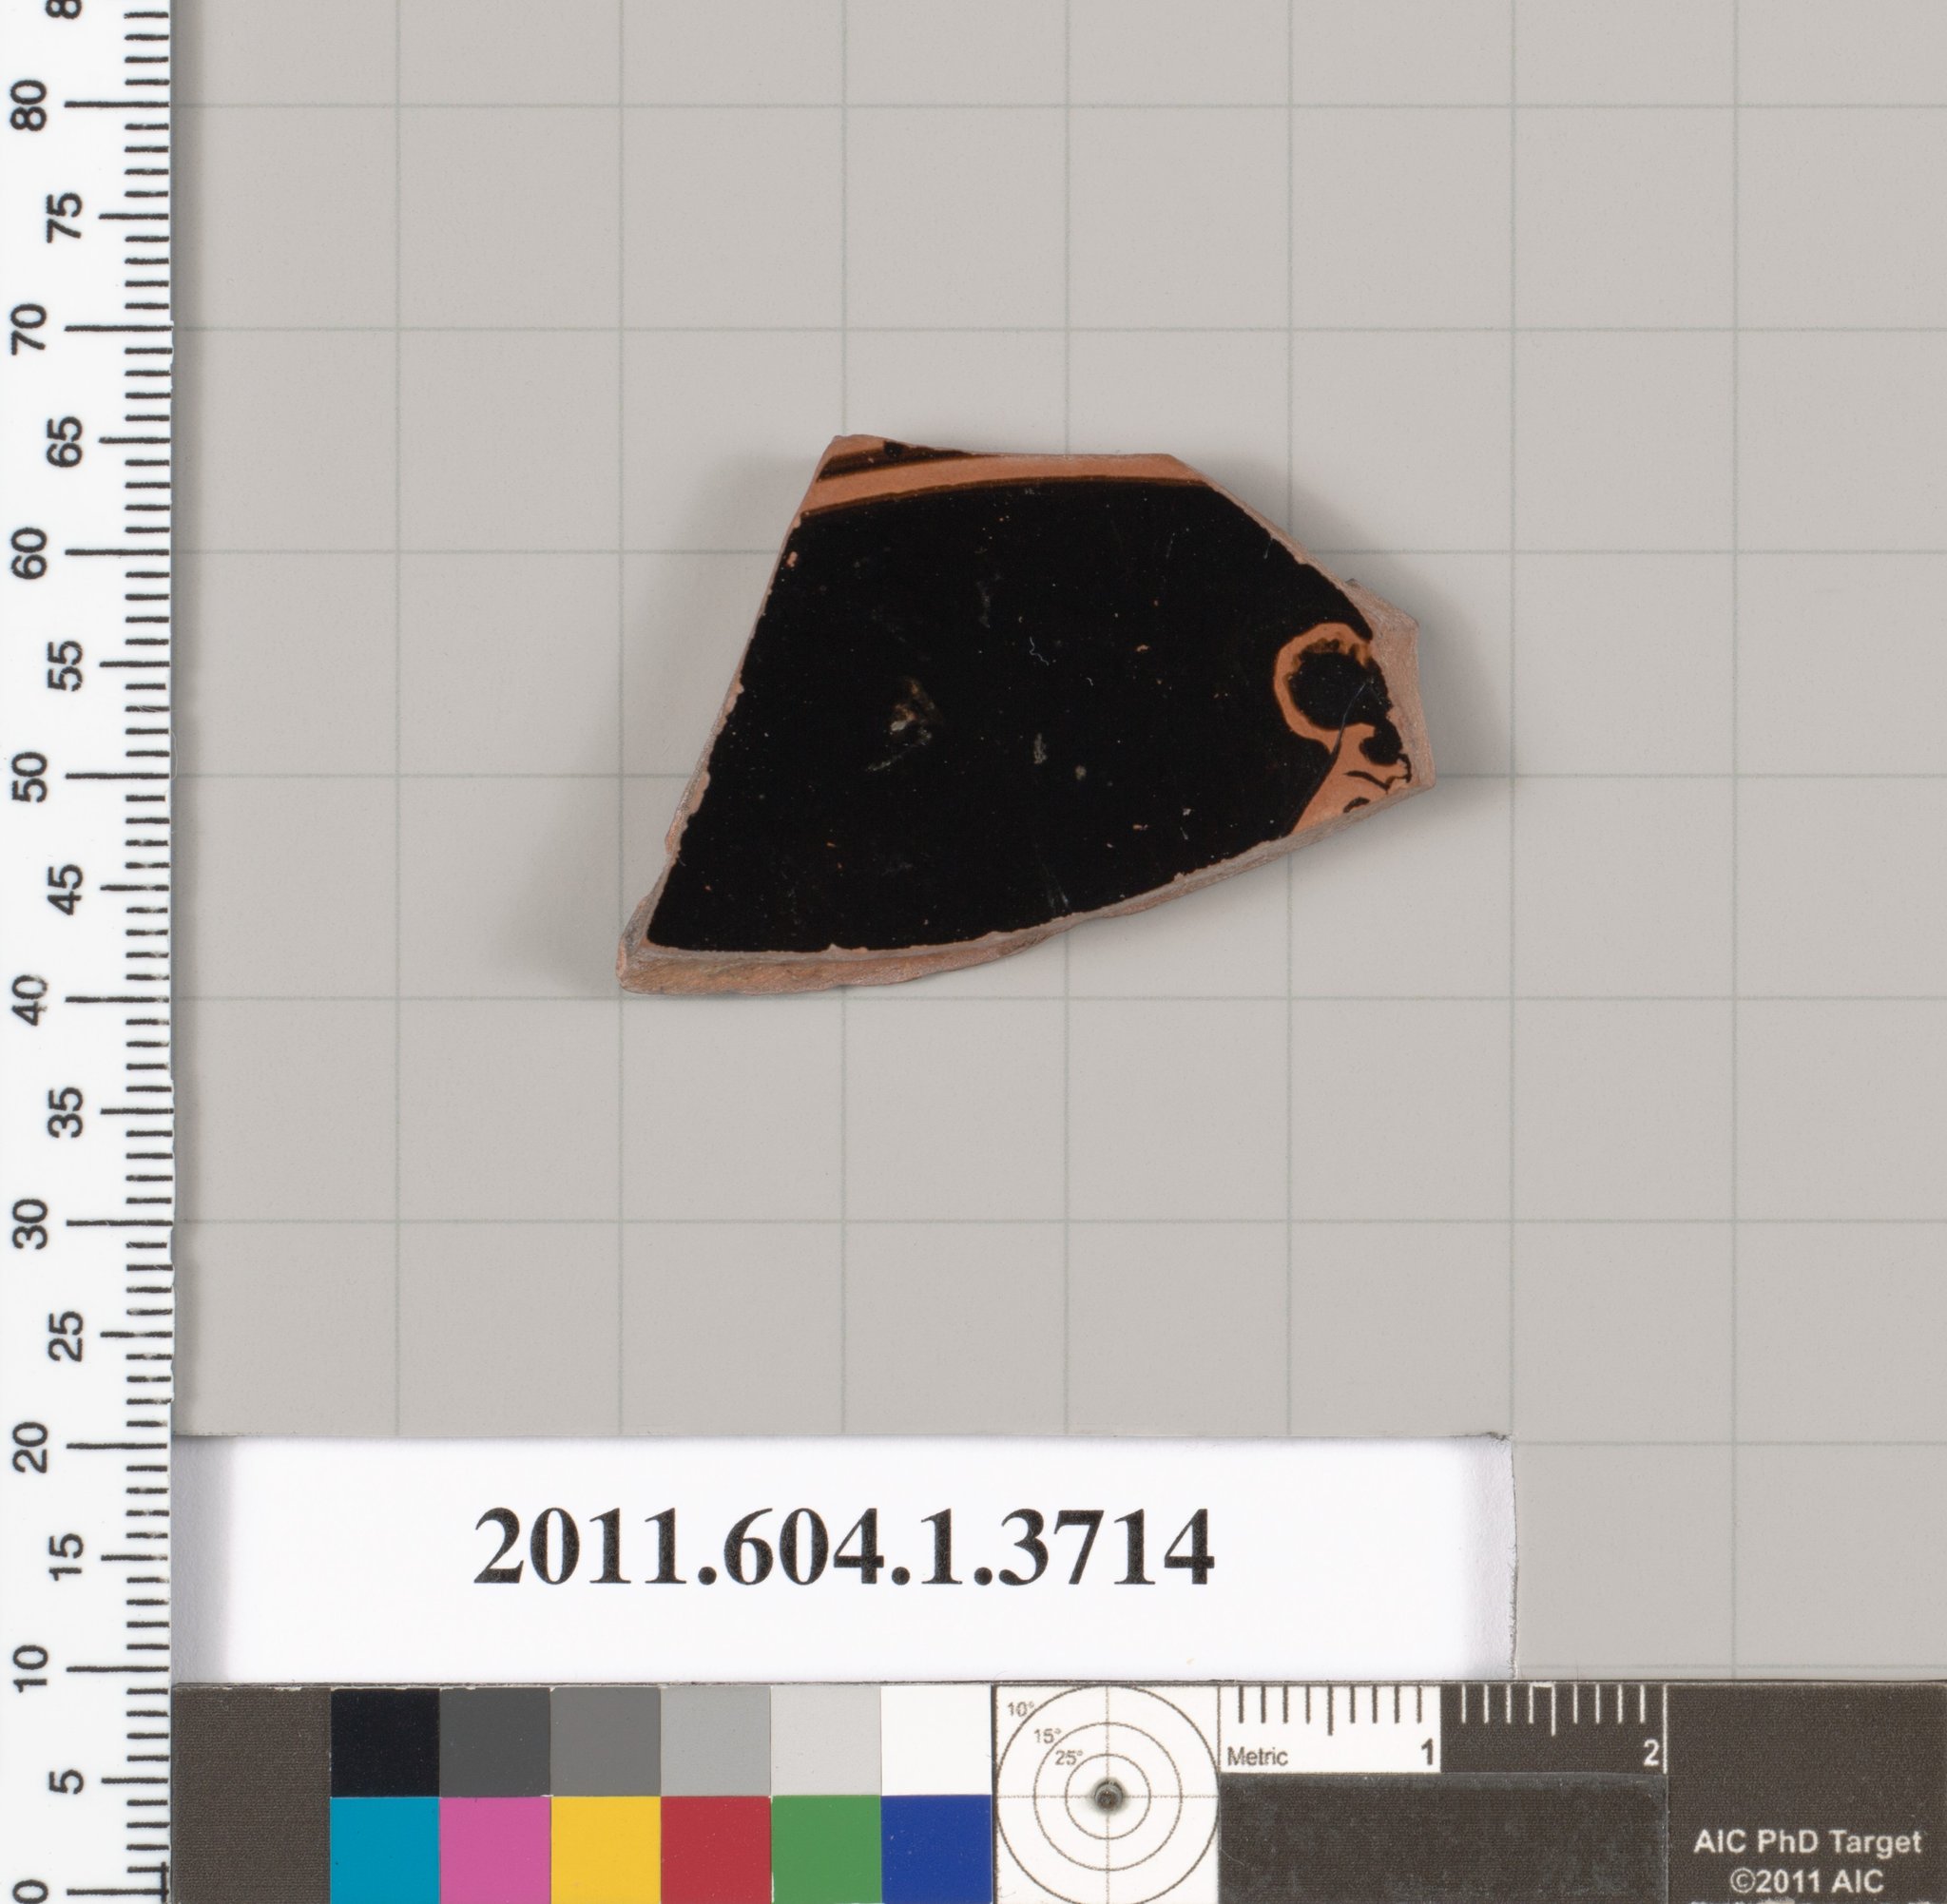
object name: kylix fragment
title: Terracotta fragment of a kylix (drinking cup)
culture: greek, attic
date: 500-480 BCE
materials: terracotta